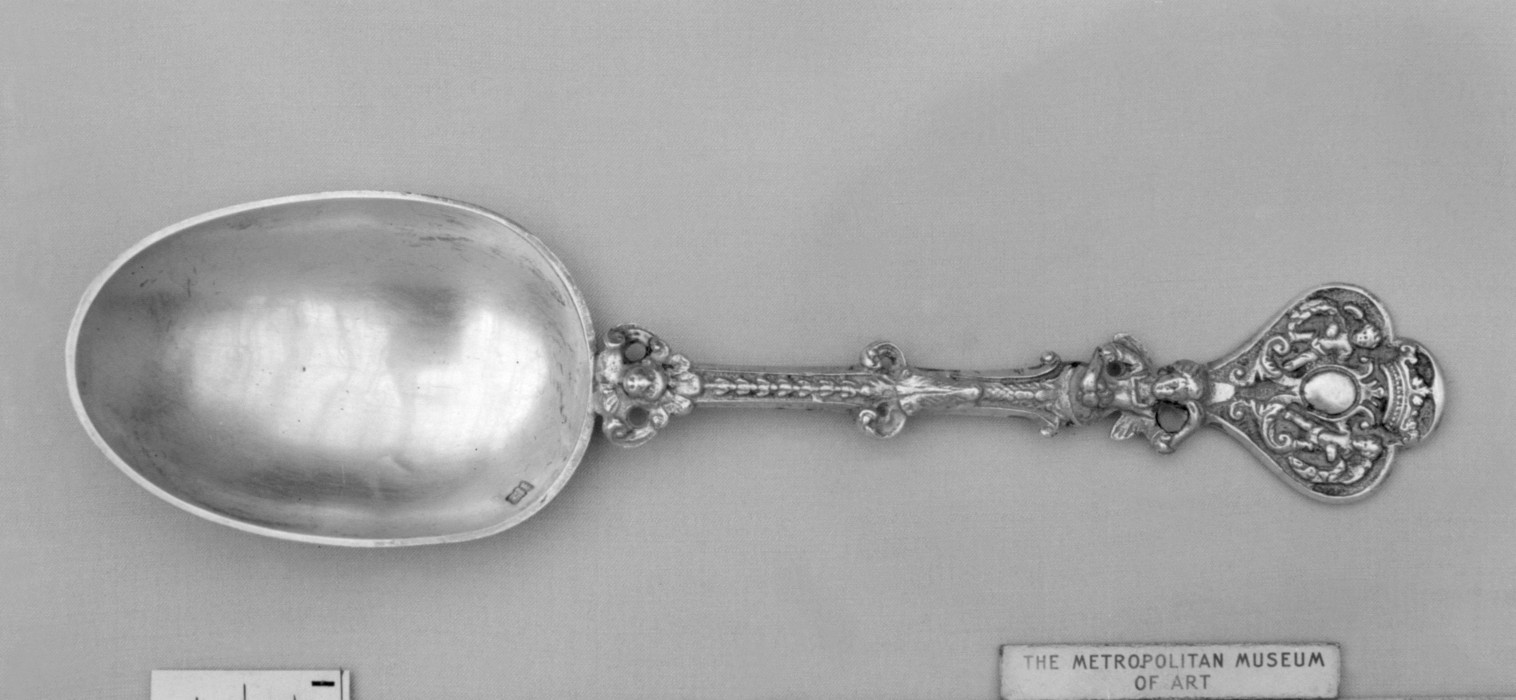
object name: spoon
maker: jacobus niebuur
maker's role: maker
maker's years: 1713-1802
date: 1734-1766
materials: silver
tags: human figures,coat of arms